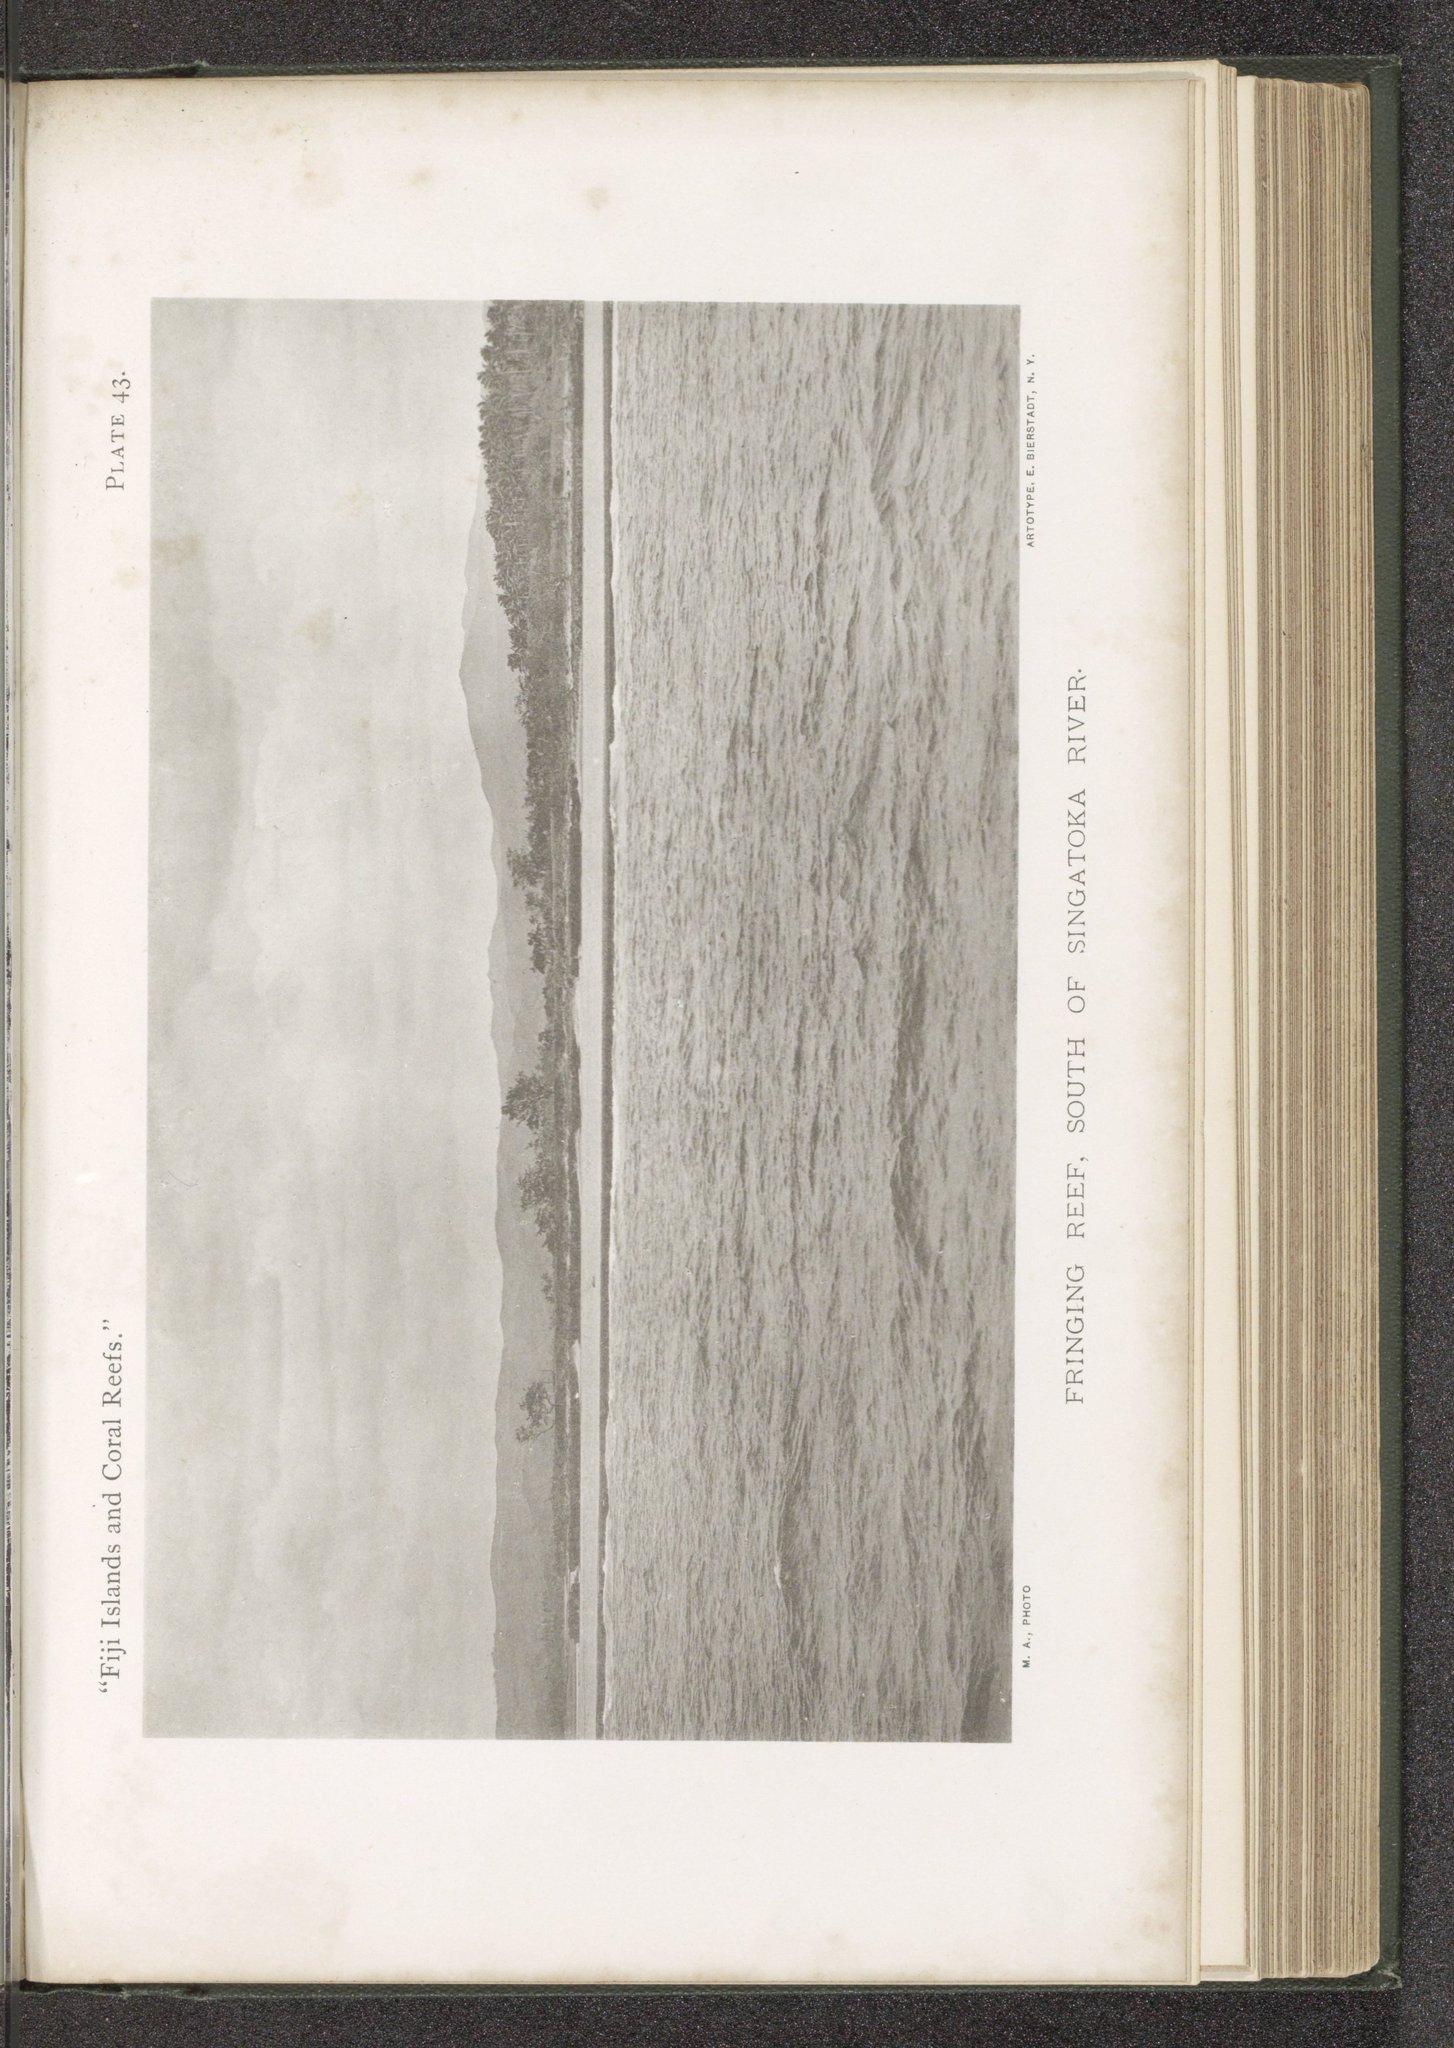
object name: page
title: Fringing reef, south of Singatoka river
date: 1885-1899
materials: paper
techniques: photograph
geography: fiji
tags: island, coral reef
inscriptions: name: ‘M. A., Photo’, number: ‘Plate 43.’, name: ‘Artotype. E. Bierstadt N. Y.’